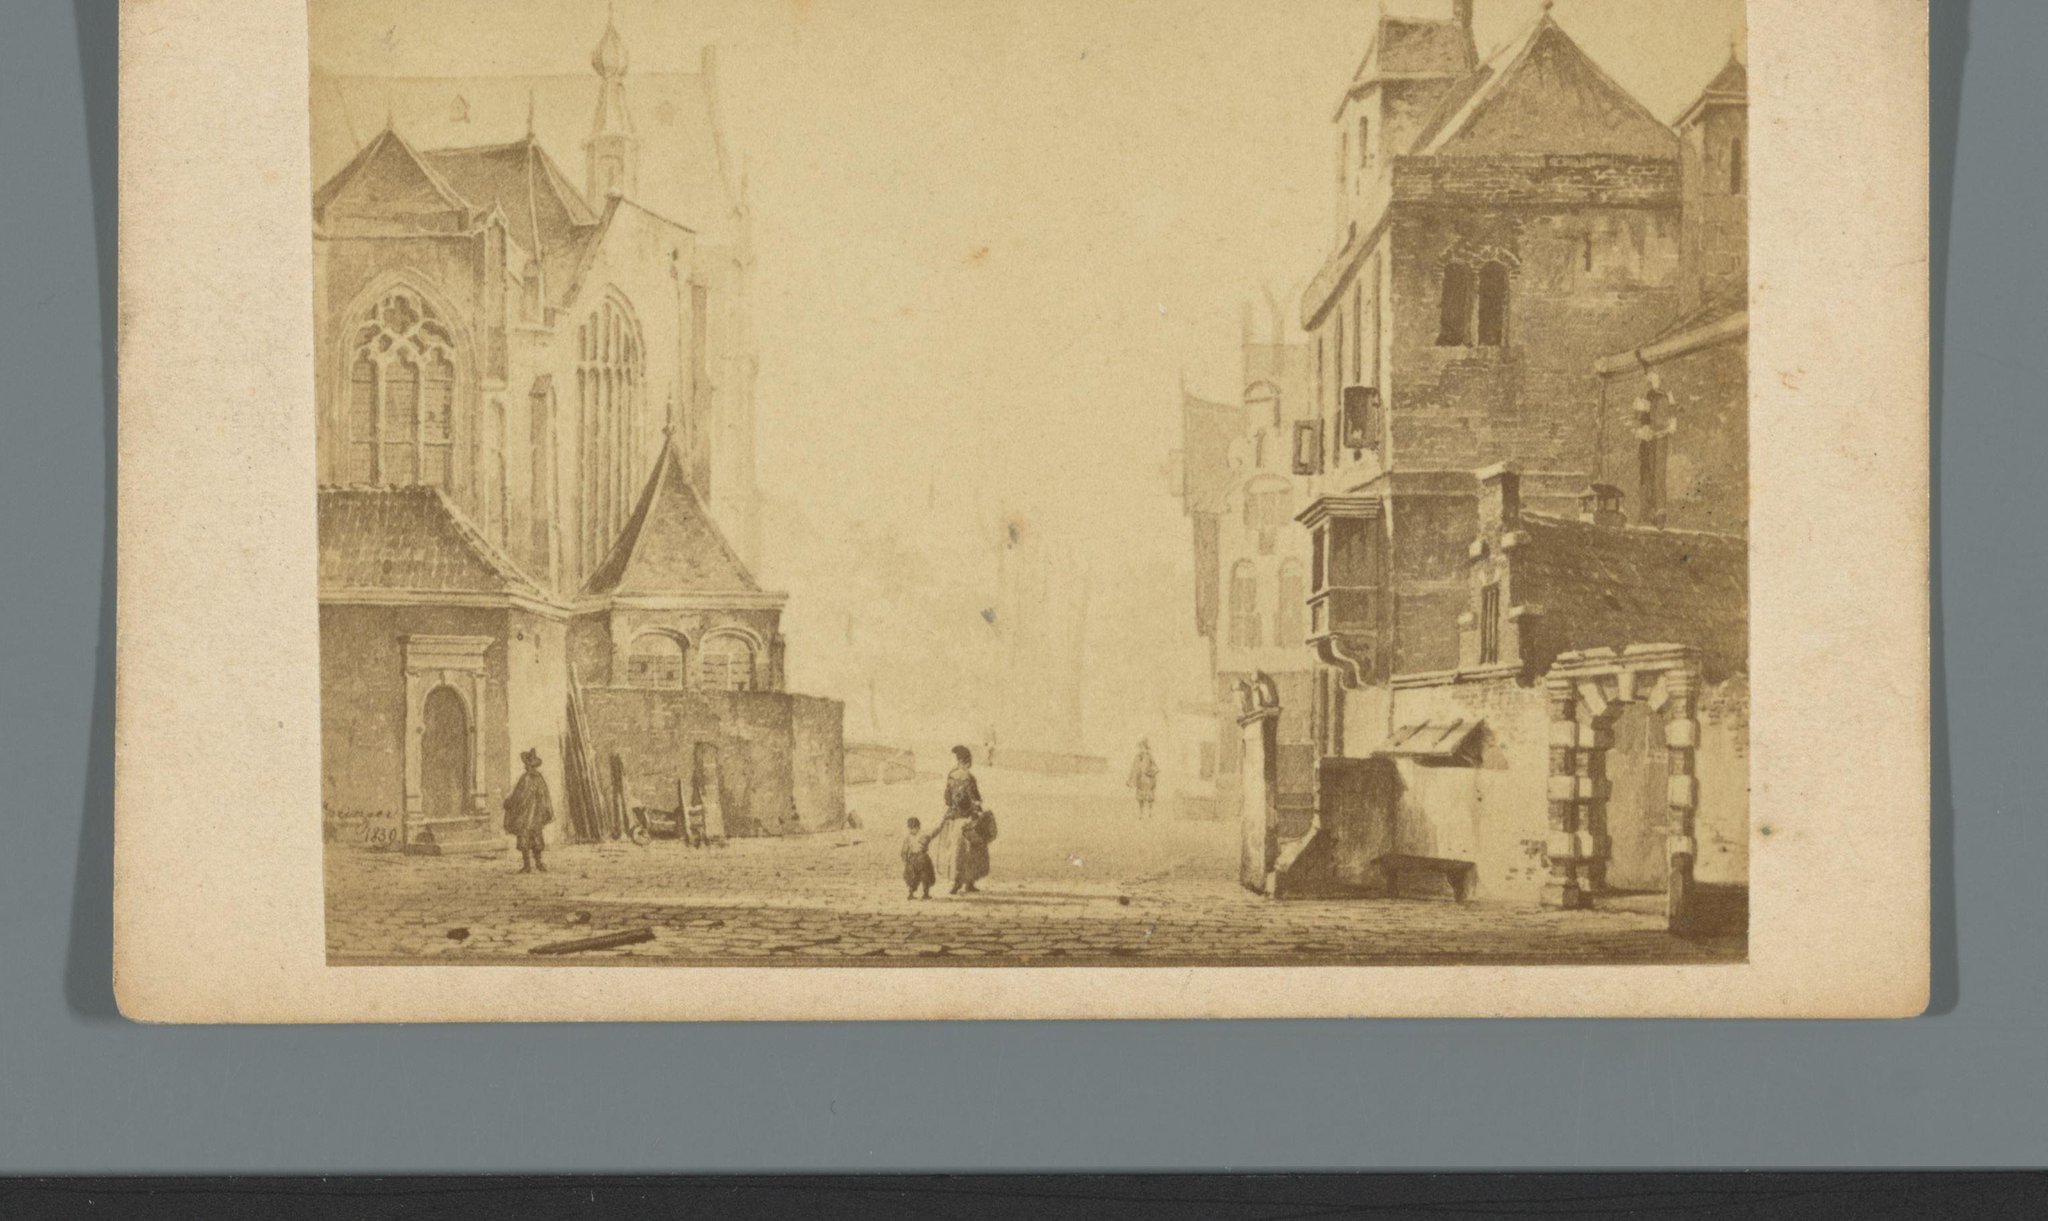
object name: carte de visite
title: Fotoreproductie van een tekening van een gezicht op een stad door Cornelis Springer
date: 1860-1900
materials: cardboard, photographic support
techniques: albumen print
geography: amsterdam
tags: prospect of city, town panorama, silhouette of city (+ city(-scape) with figures, staffage)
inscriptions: inscription: ‘No. 6./ VUE DE VILLE./ PHOTOGRAPHIE D'APRÈS LE DESSIN ORIGINAL DE/ C. SPRINGER./ Publié par/ A. JAGER,/ Water, 110, Amsterdam.’